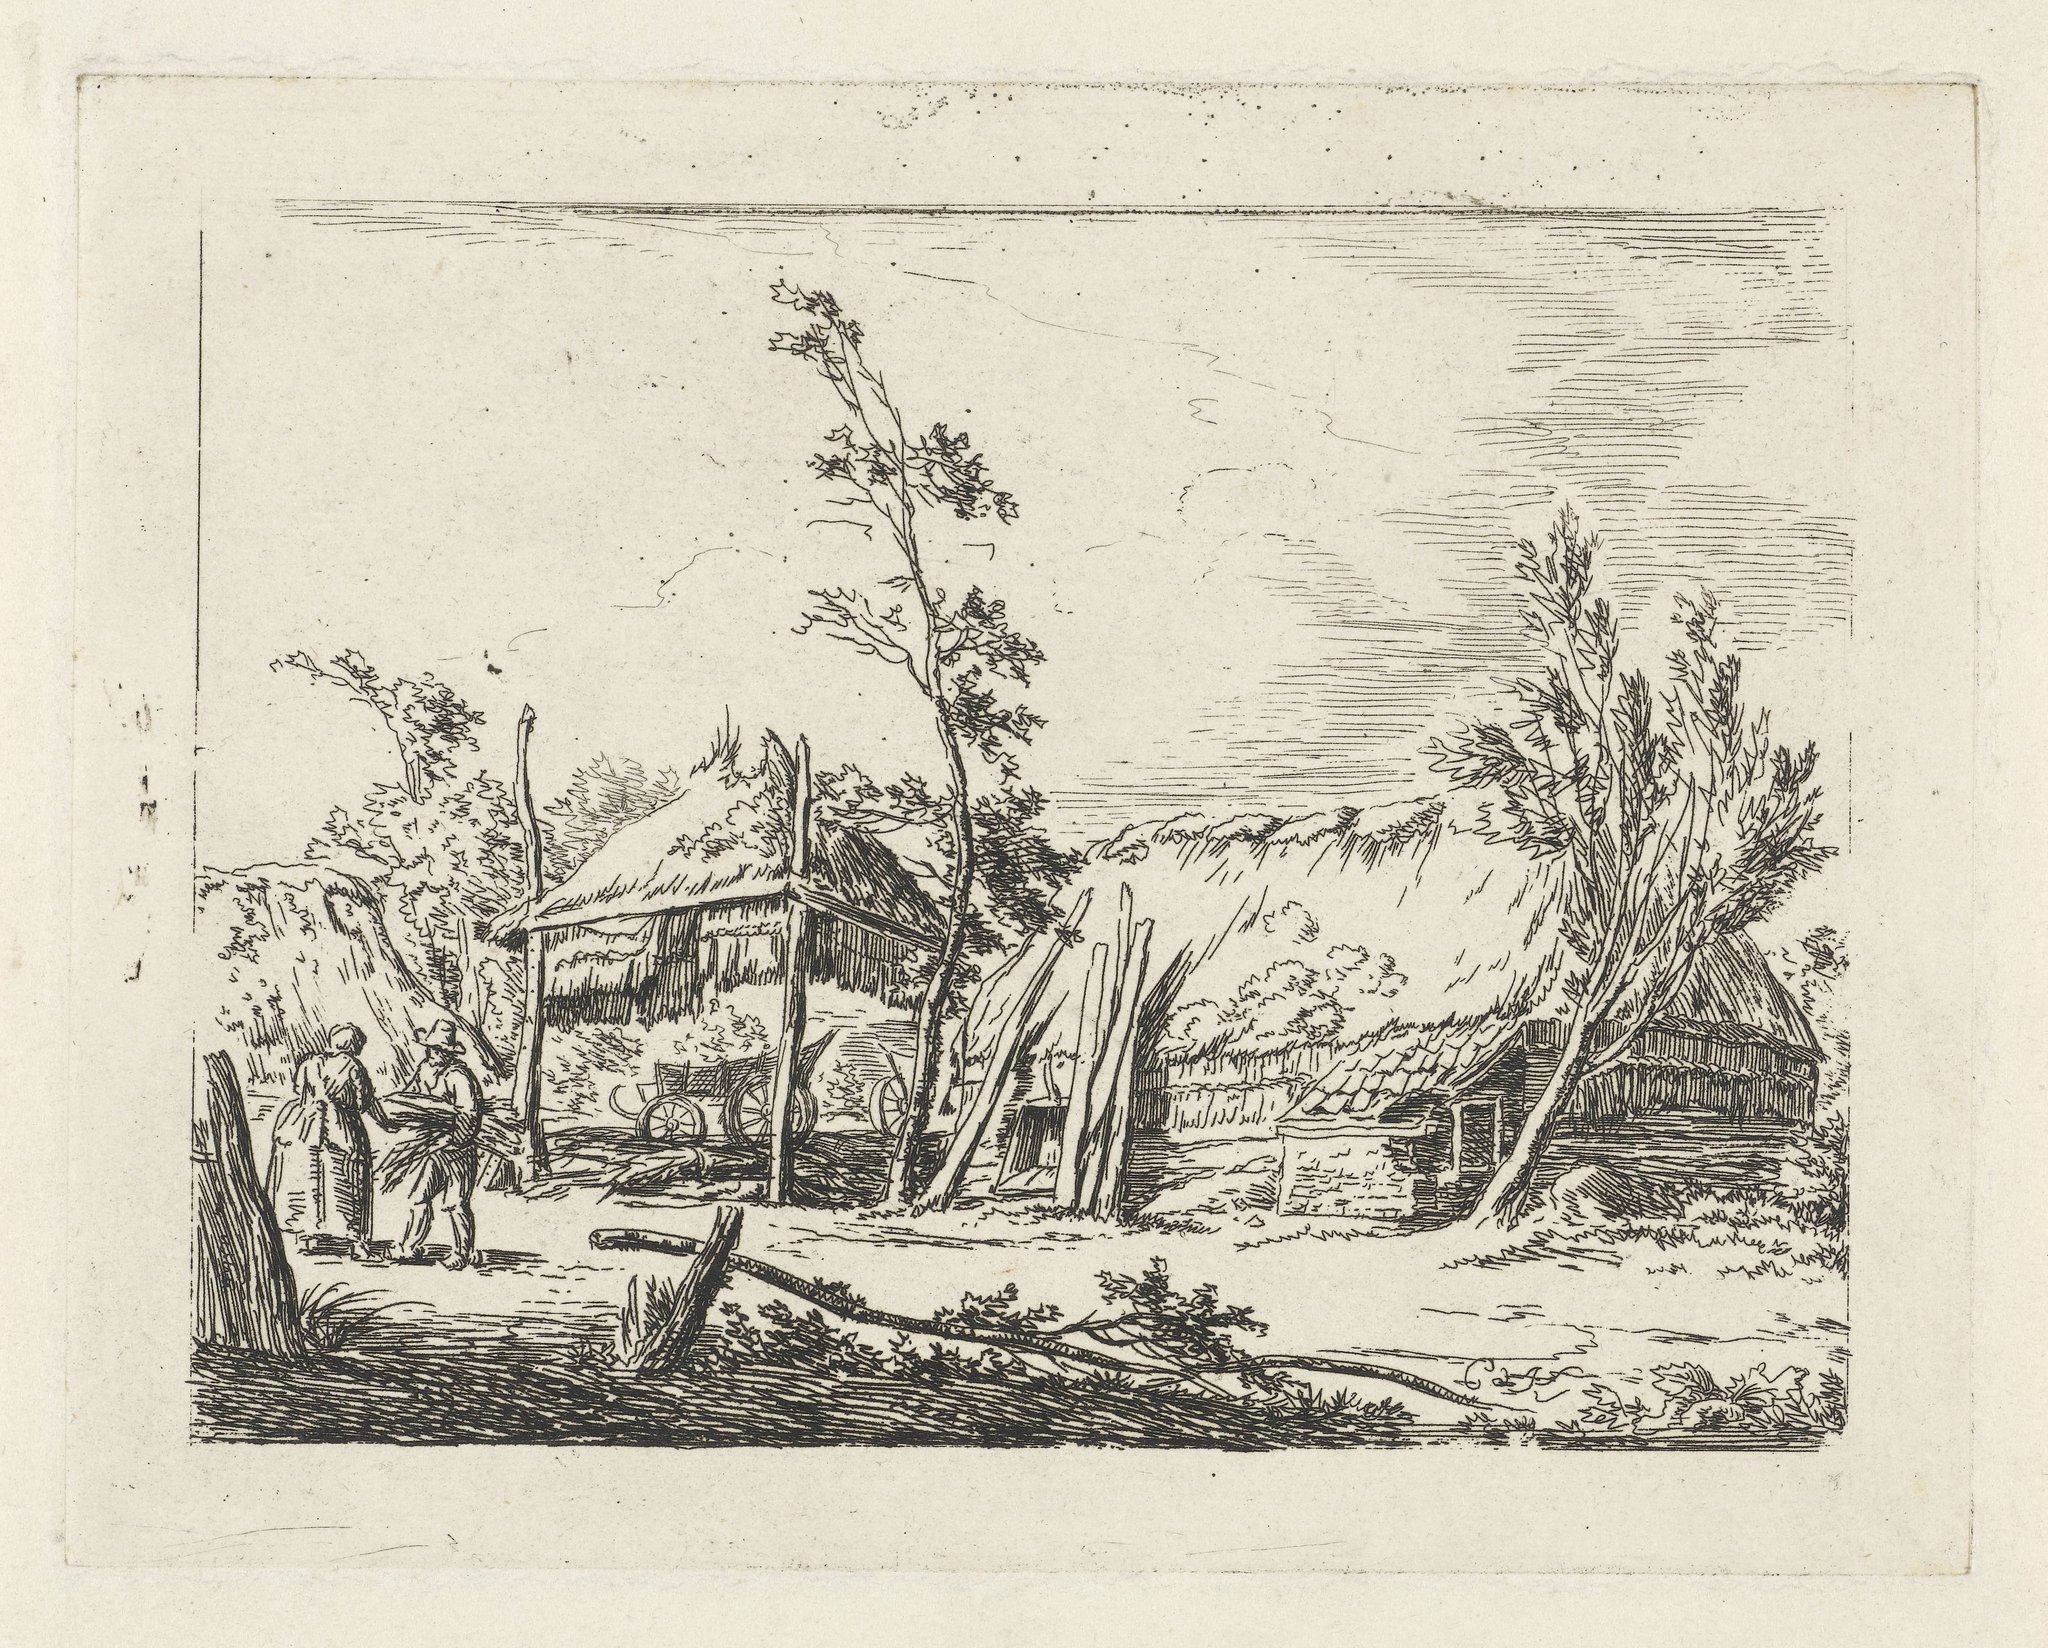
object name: print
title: Boerderij met hooiberg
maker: cornelis de kruyff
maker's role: draughtsman, print maker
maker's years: 1774-1828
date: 1784-1828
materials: paper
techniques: etching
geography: amsterdam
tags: hay-stack, farm or solitary house in landscape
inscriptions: collector's mark: Lugt 2228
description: Een boerderij met een hooiberg waar een boerenkar onder staat. Links een man en een vrouw. De man heeft een bos stro onder de arm.